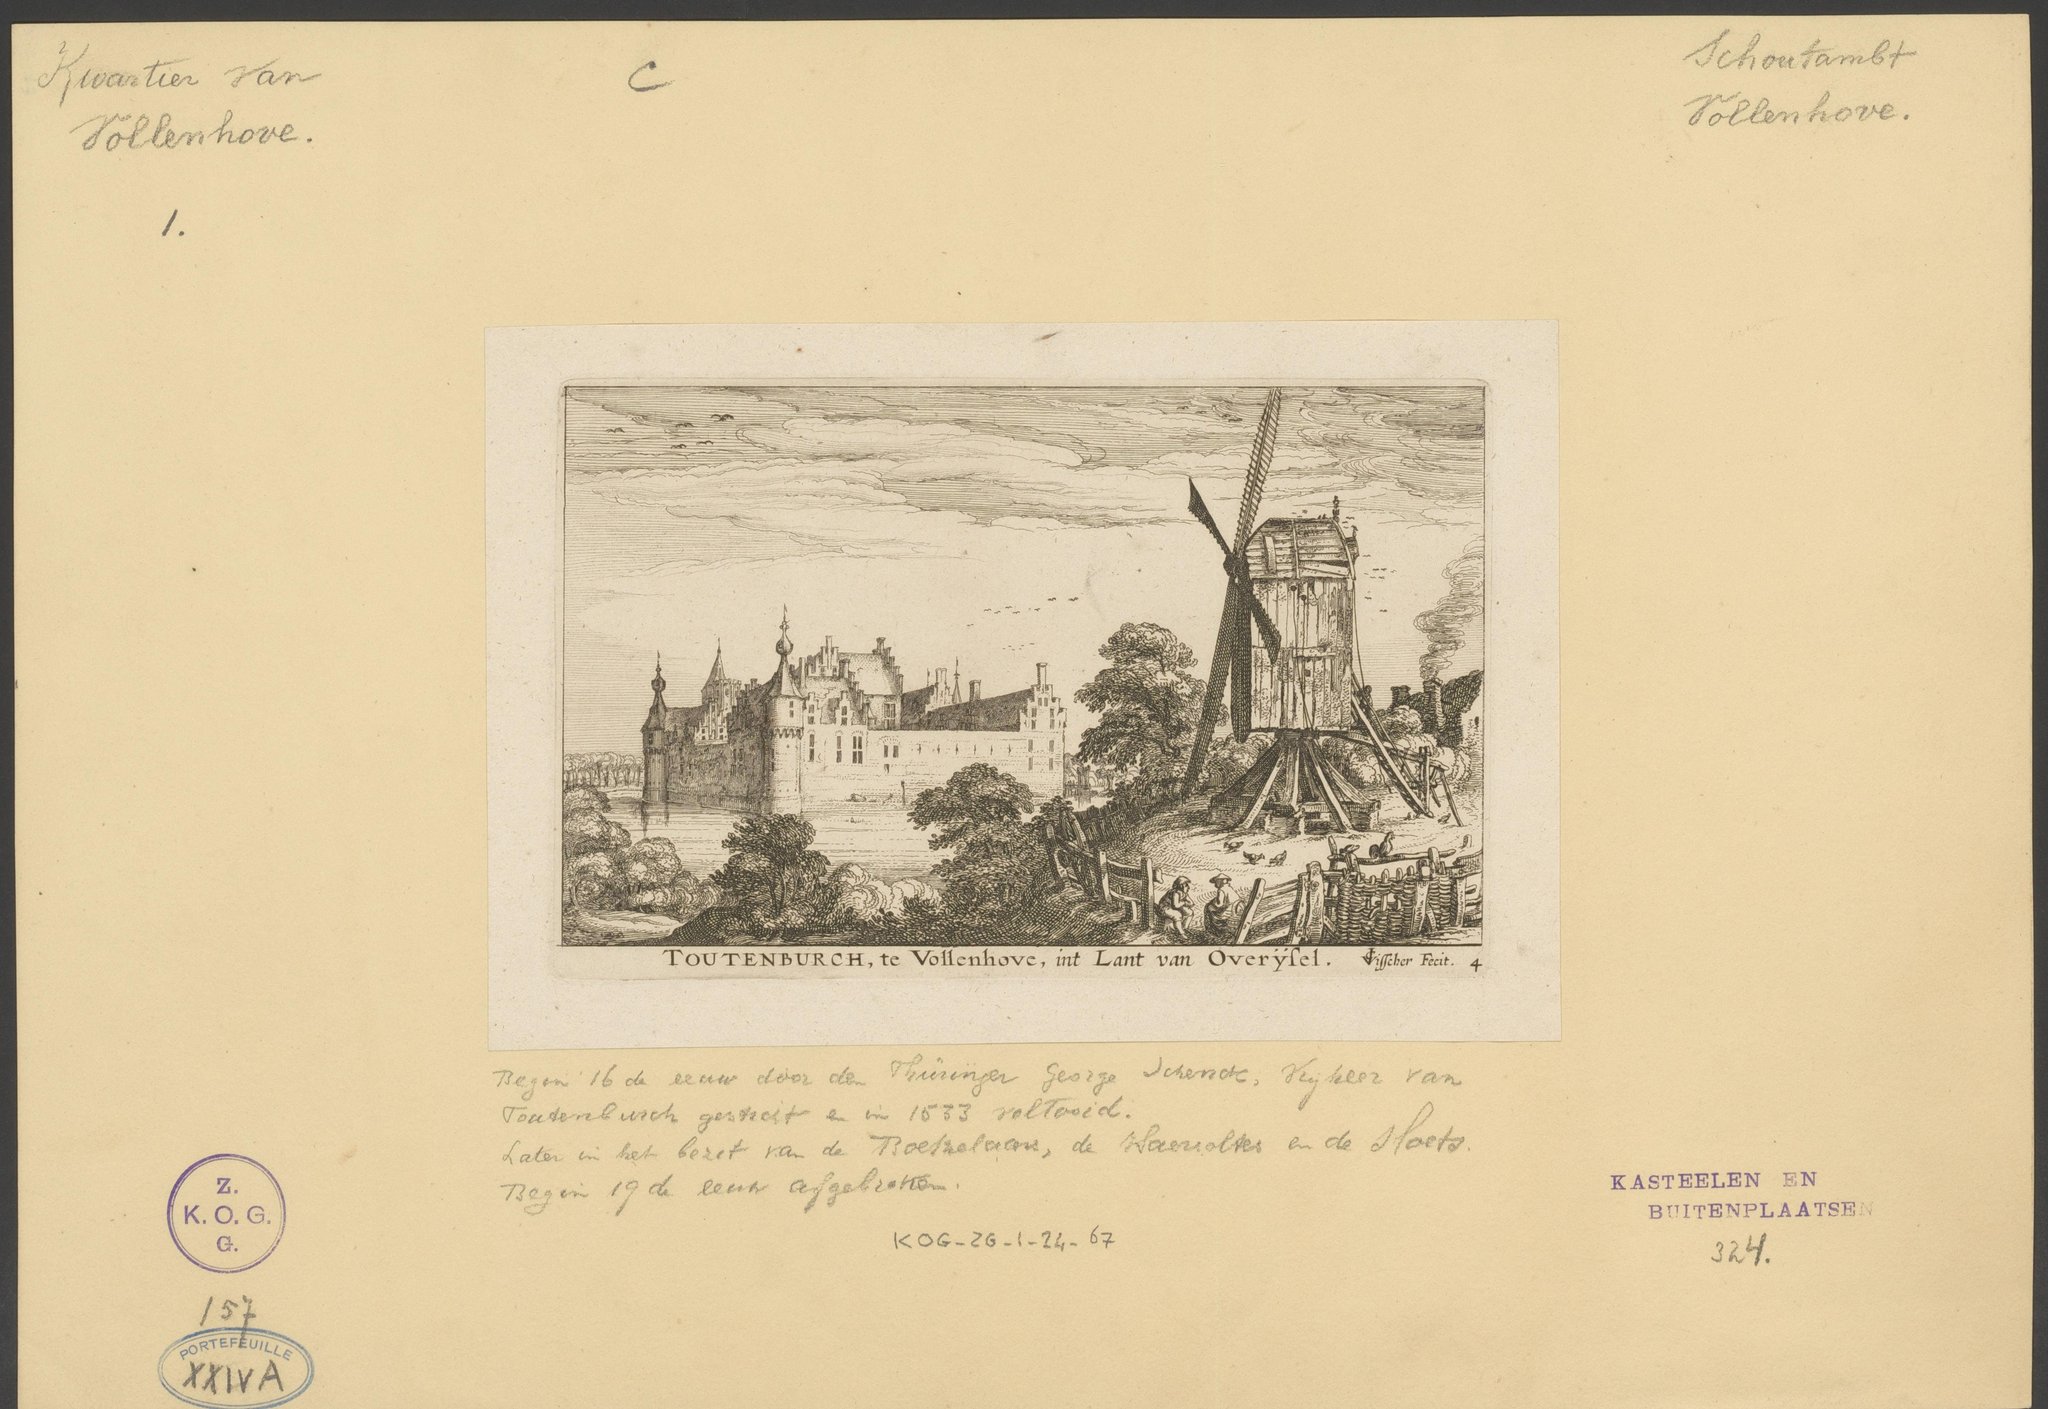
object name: print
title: Toutenburch, te Vollenhove, int Lant van Overijsel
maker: claes jansz. visscher (ii)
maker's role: draughtsman, print maker, publisher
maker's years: 1586-1652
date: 1617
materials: paper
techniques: engraving, etching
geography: amsterdam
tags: castle, wheelbarrow, utrecht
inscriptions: stamp, stamp, collector's mark: Lugt 1641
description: Rechtsonder genummerd: 4. Onderwerpsrubrieken binnen de Atlas Zeden en Gewoonten: Zeden en Gewoonten in Engeren Zin, De Woning. Kastelen en buitenplaatsen. Overijssel.